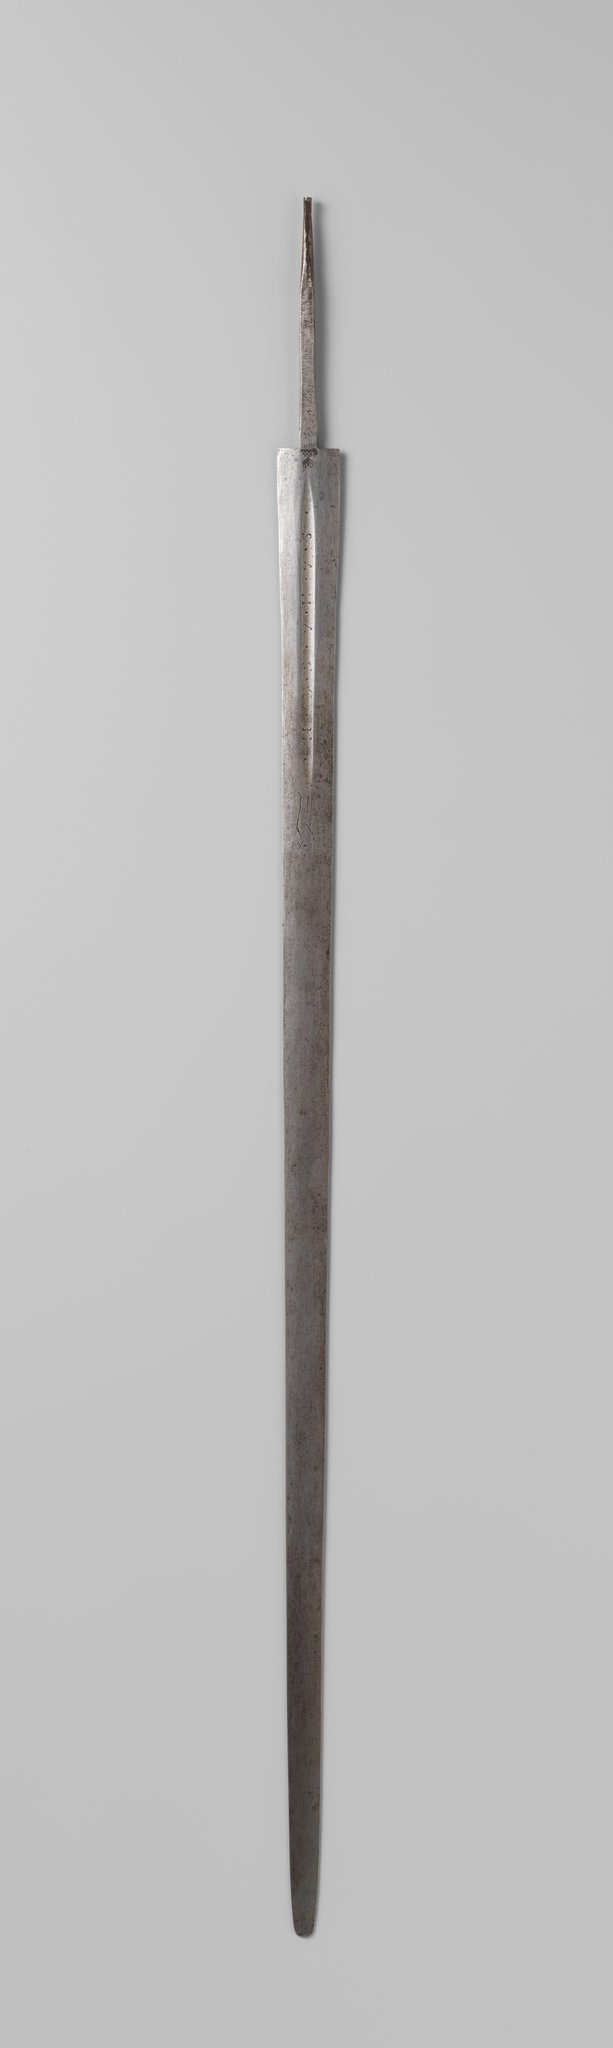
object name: knife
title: Kling voor ruiterdegen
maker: Anonymous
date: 1550-1900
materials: iron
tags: netherlands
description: Kling voor ruiterdegen met opschrift: SAHAGOM en afbeelding van een lopend dier (wolfskling).